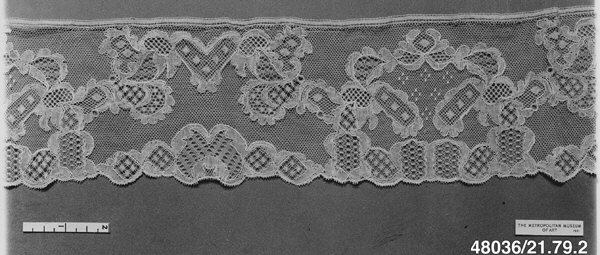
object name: strip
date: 1801-1900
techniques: lace